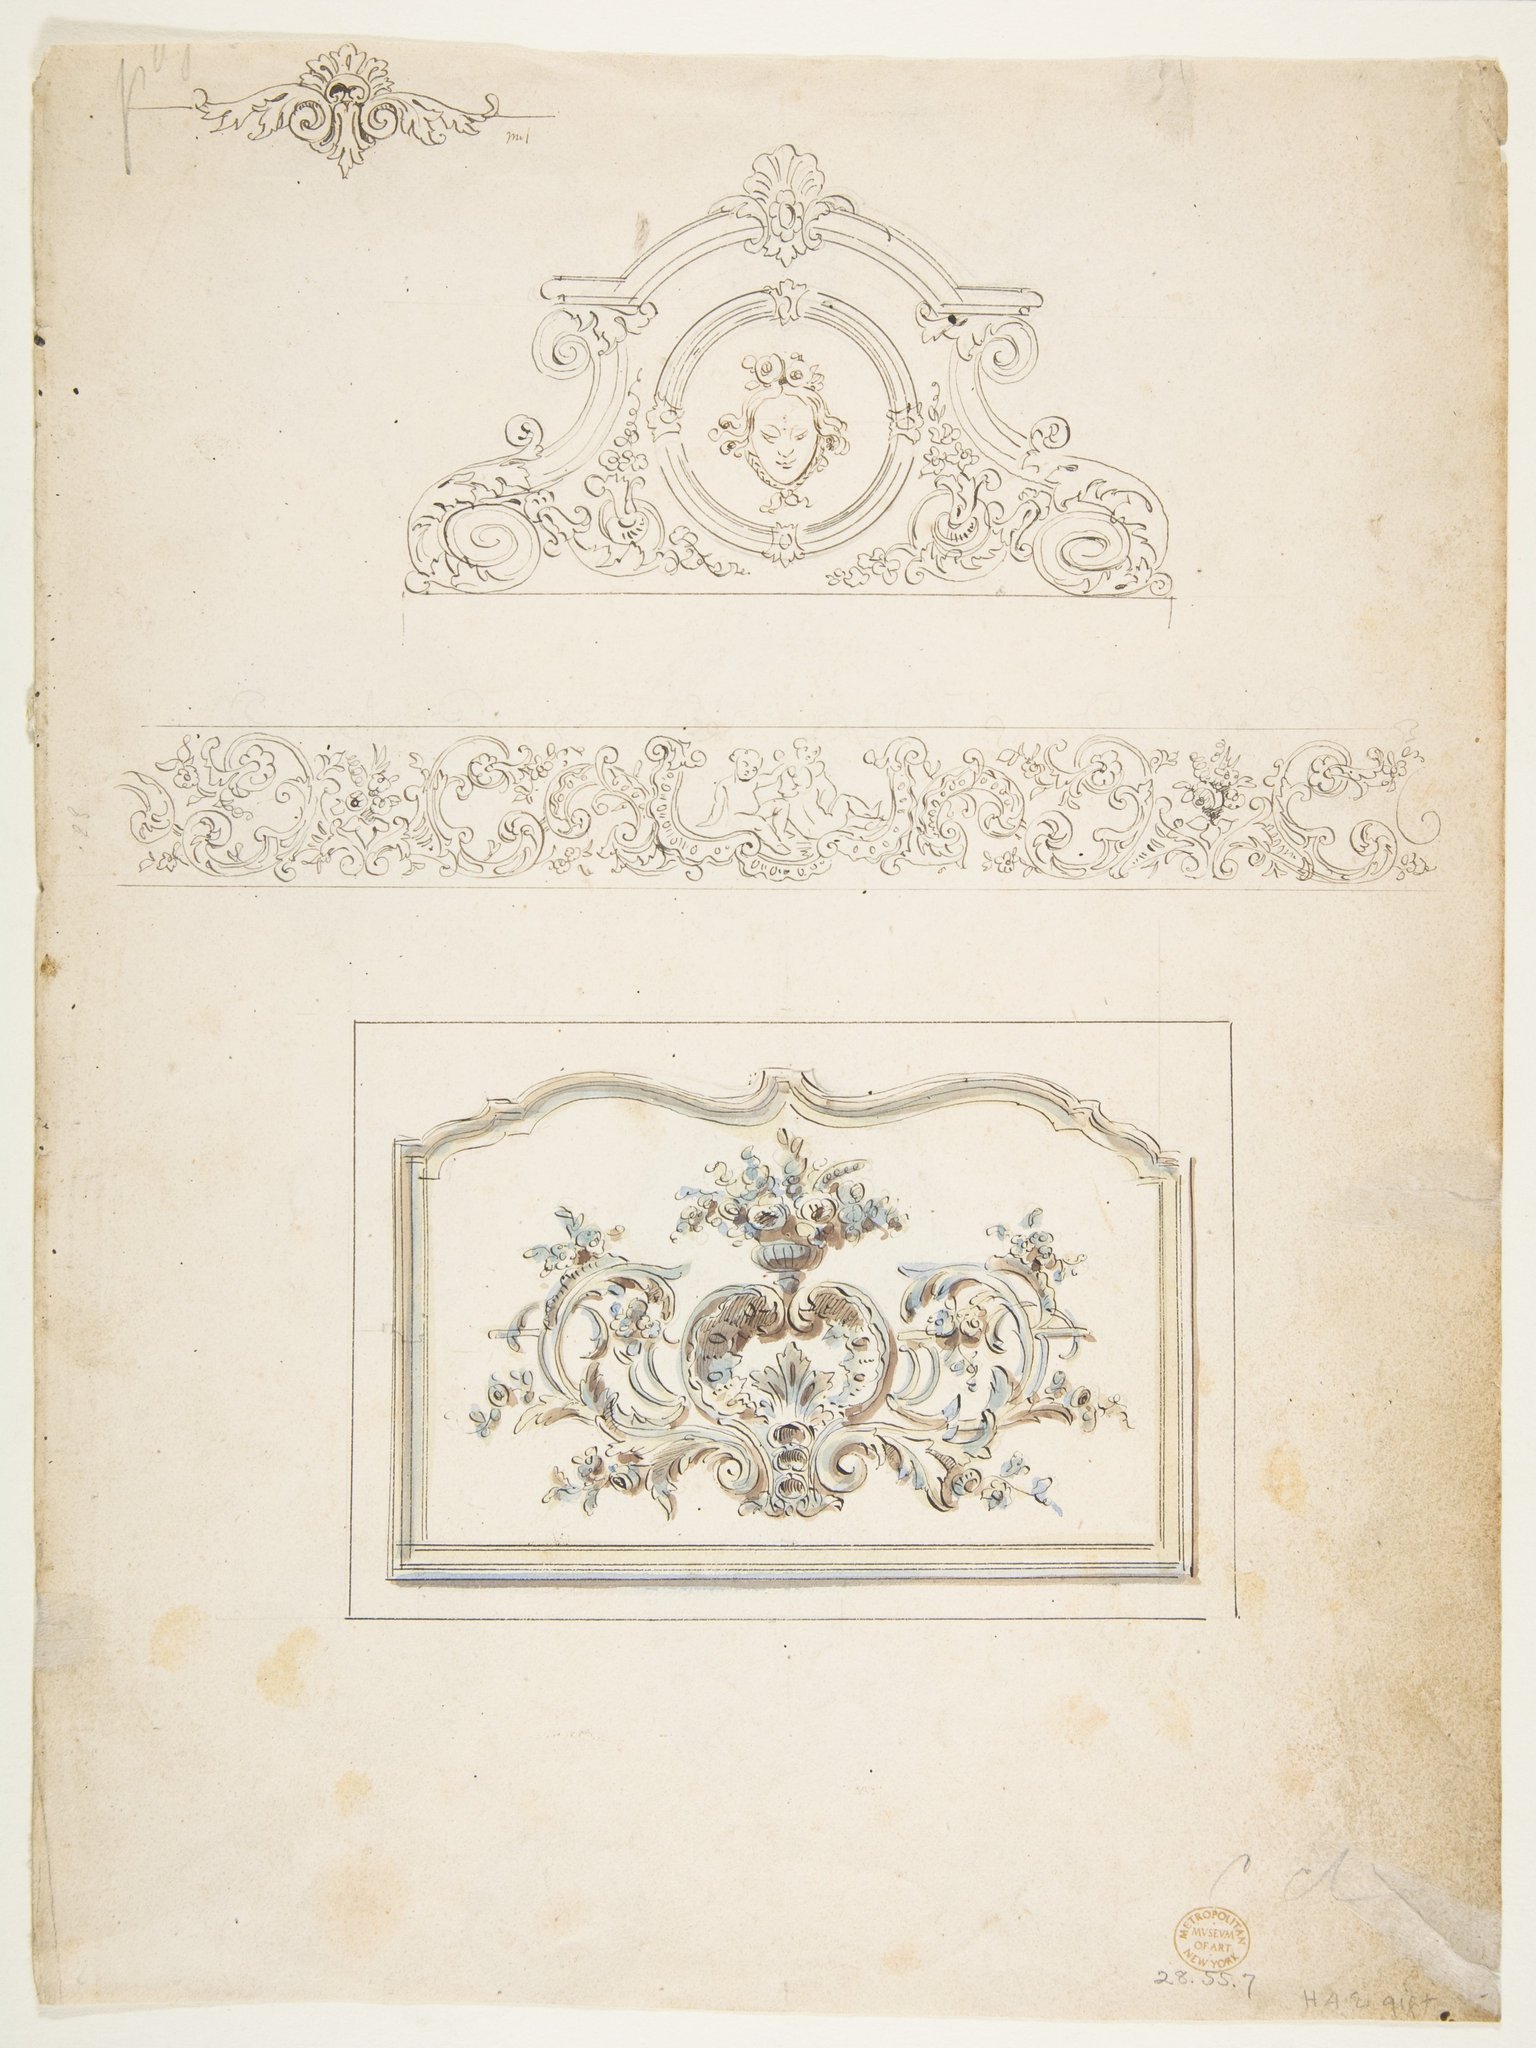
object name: drawing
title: Border and Three Pediments (recto), Fifteen circular Designs (verso)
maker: anonymous, french, 18th century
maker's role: artist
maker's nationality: french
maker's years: 1700-1800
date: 1701-1800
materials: graphite, ink, paper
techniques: pen, wash